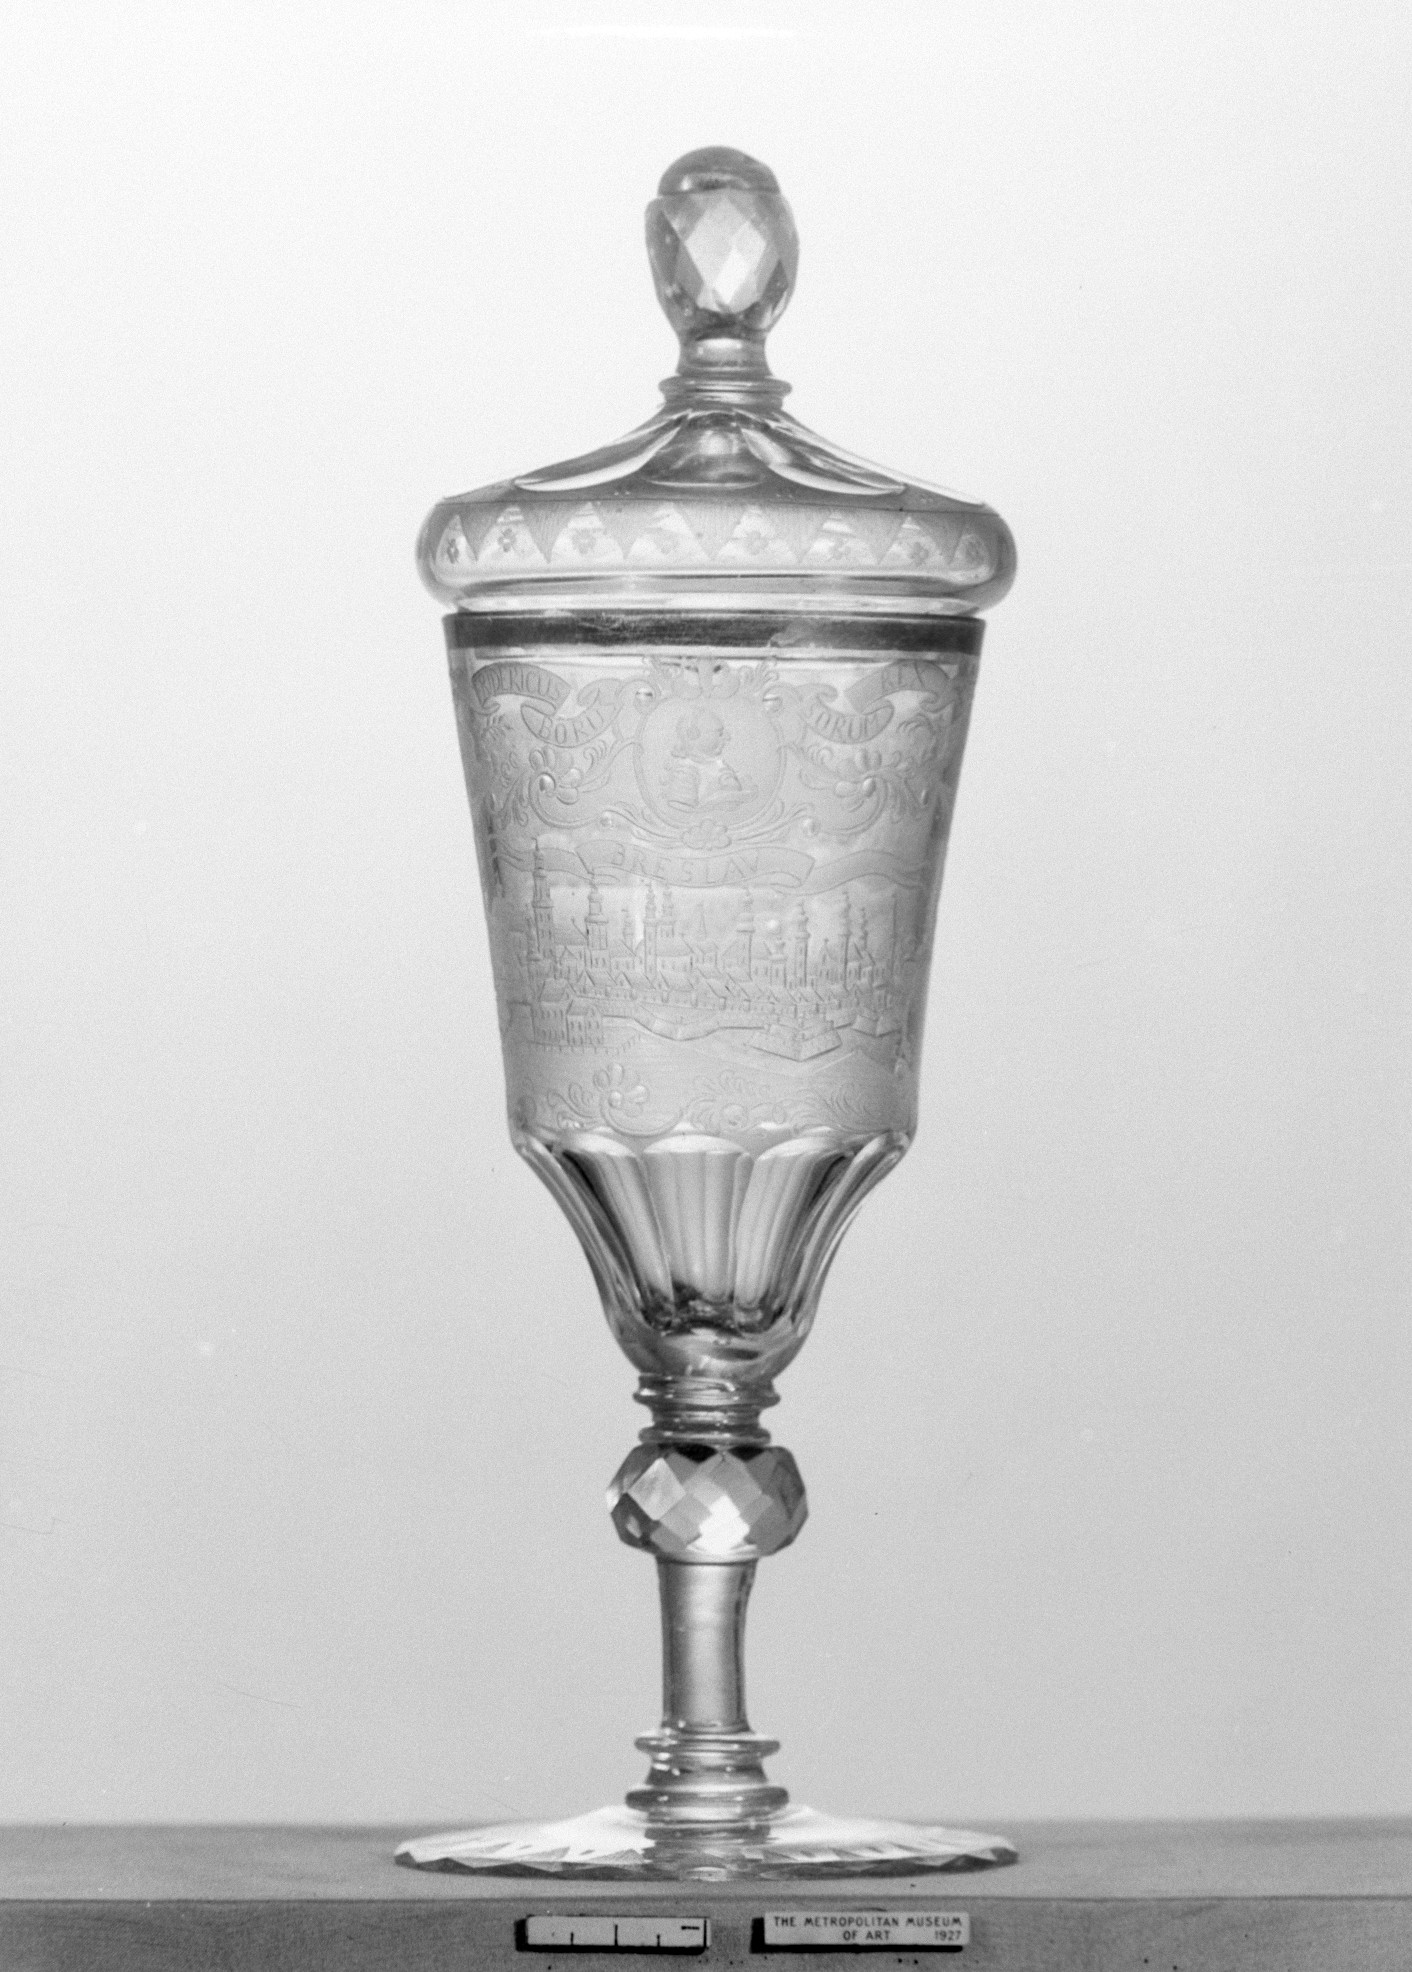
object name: standing cup with cover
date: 1755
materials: glass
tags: benjamin franklin,coat of arms